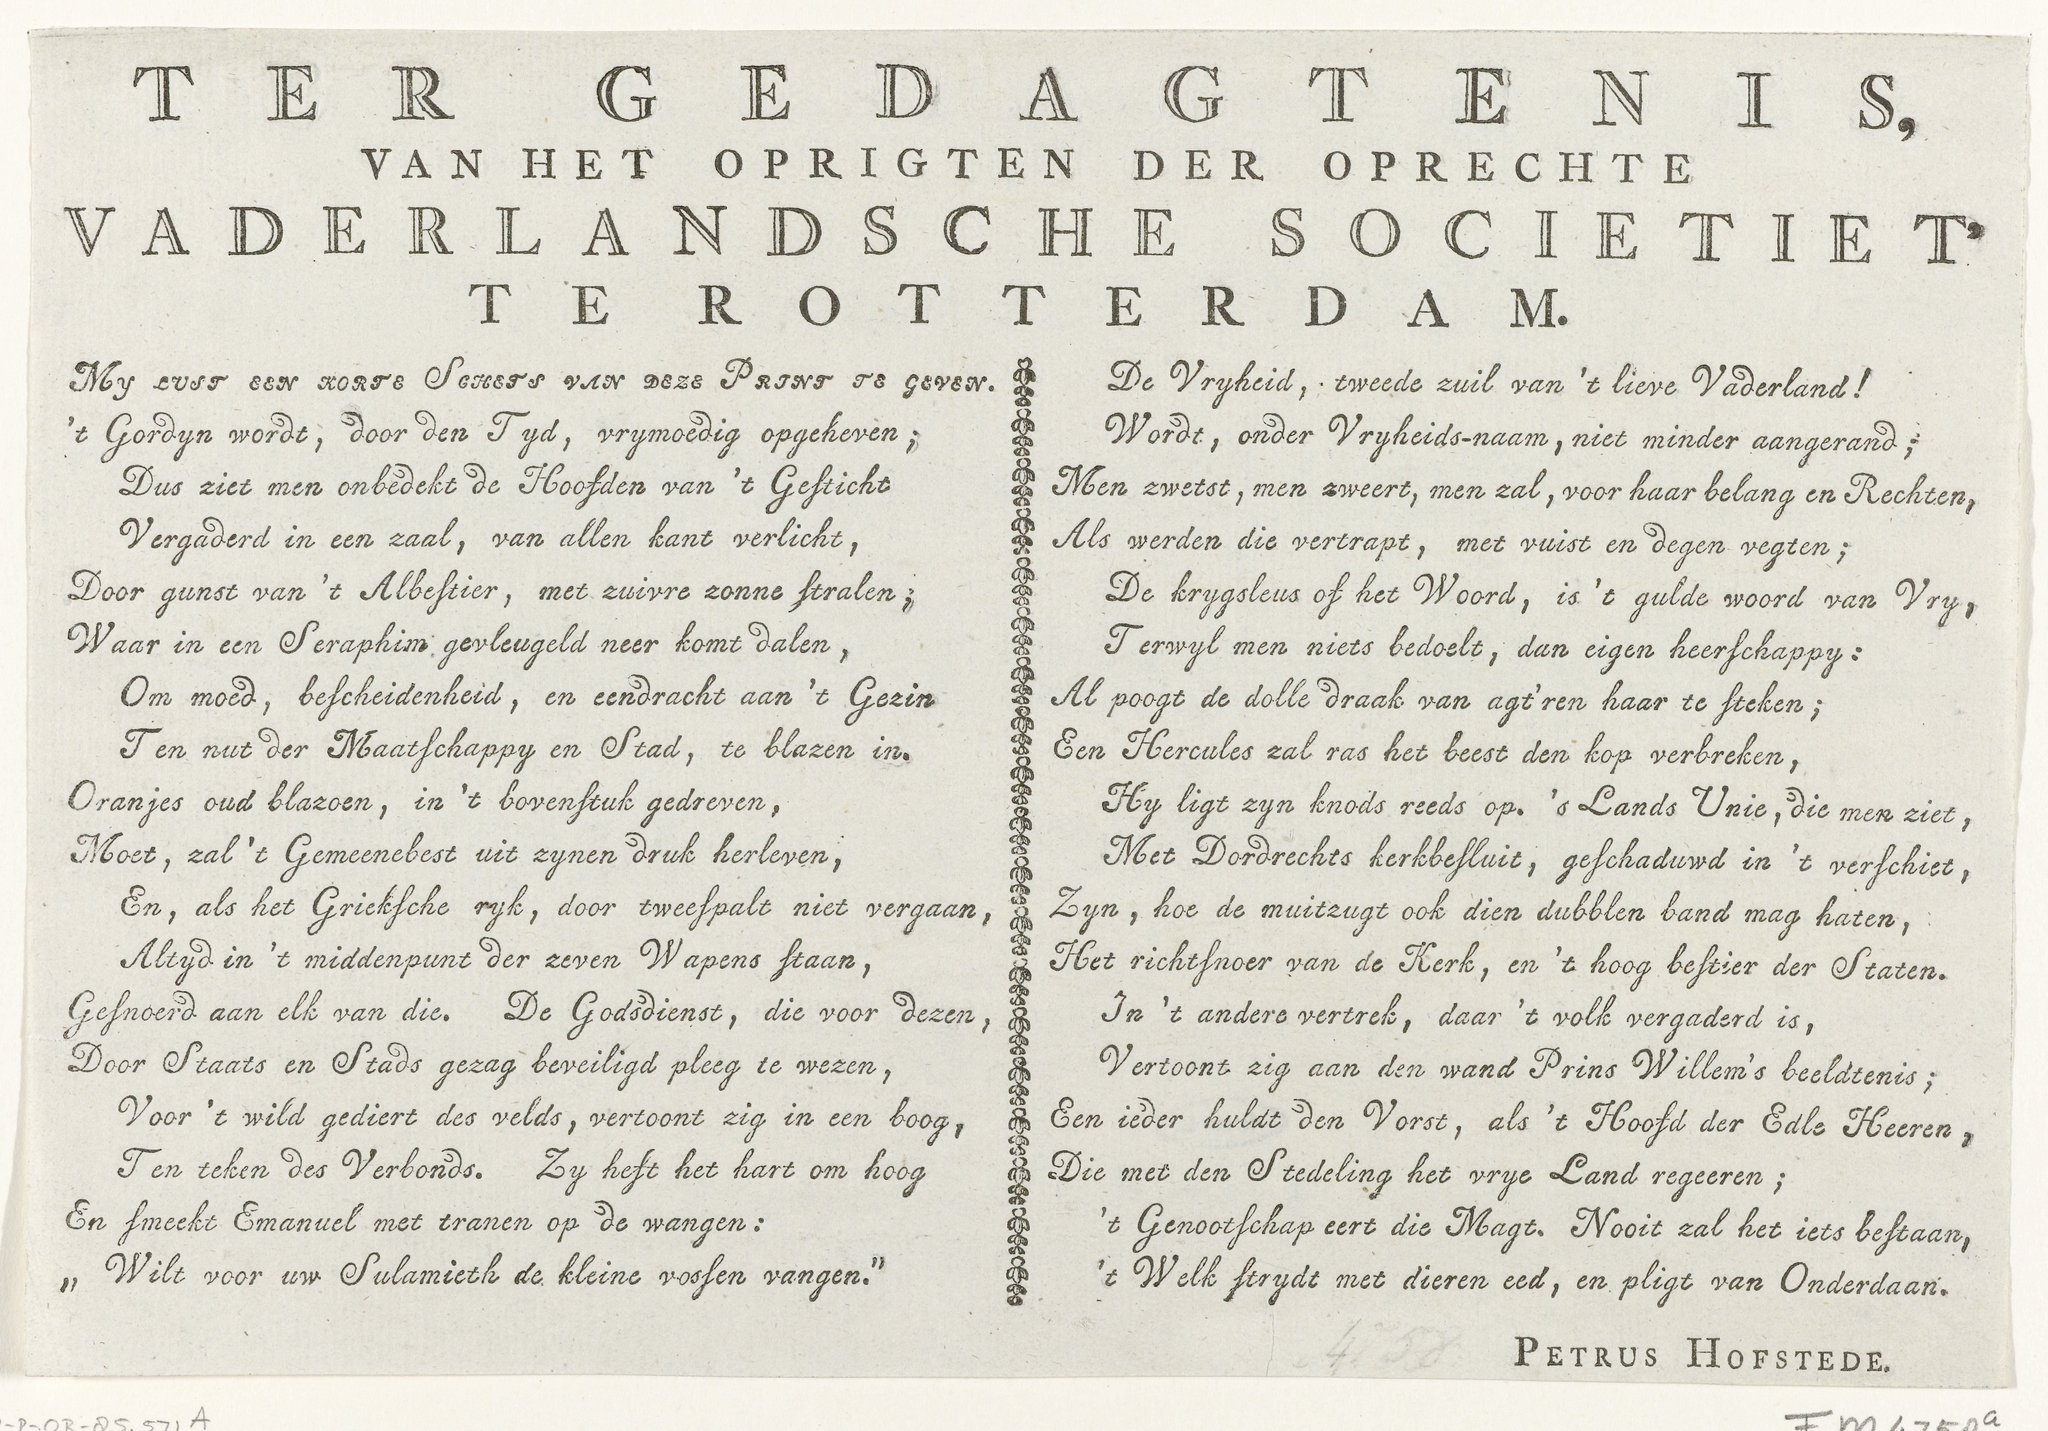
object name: text sheet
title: Tekstblad bij de prent met de allegorie op de oprichting van de Oprechte Vaderlandsche Sociëteit te Rotterdam, 1787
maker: petrus hofstede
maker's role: predikant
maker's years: 1716-1803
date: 1787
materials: paper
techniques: letterpress printing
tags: the hague, william v (prince of orange), rotterdam, patriots (1780-1795)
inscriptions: collector's mark: Lugt 2228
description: Tekstblad met een verklaring van de prent met de allegorie op de oprichting van het orangistische genootschap de Oprechte Vaderlandsche Sociëteit te Rotterdam, 7 of 18 januari 1787. Verklaring van de voorstelling in versvorm in twee kolommen.